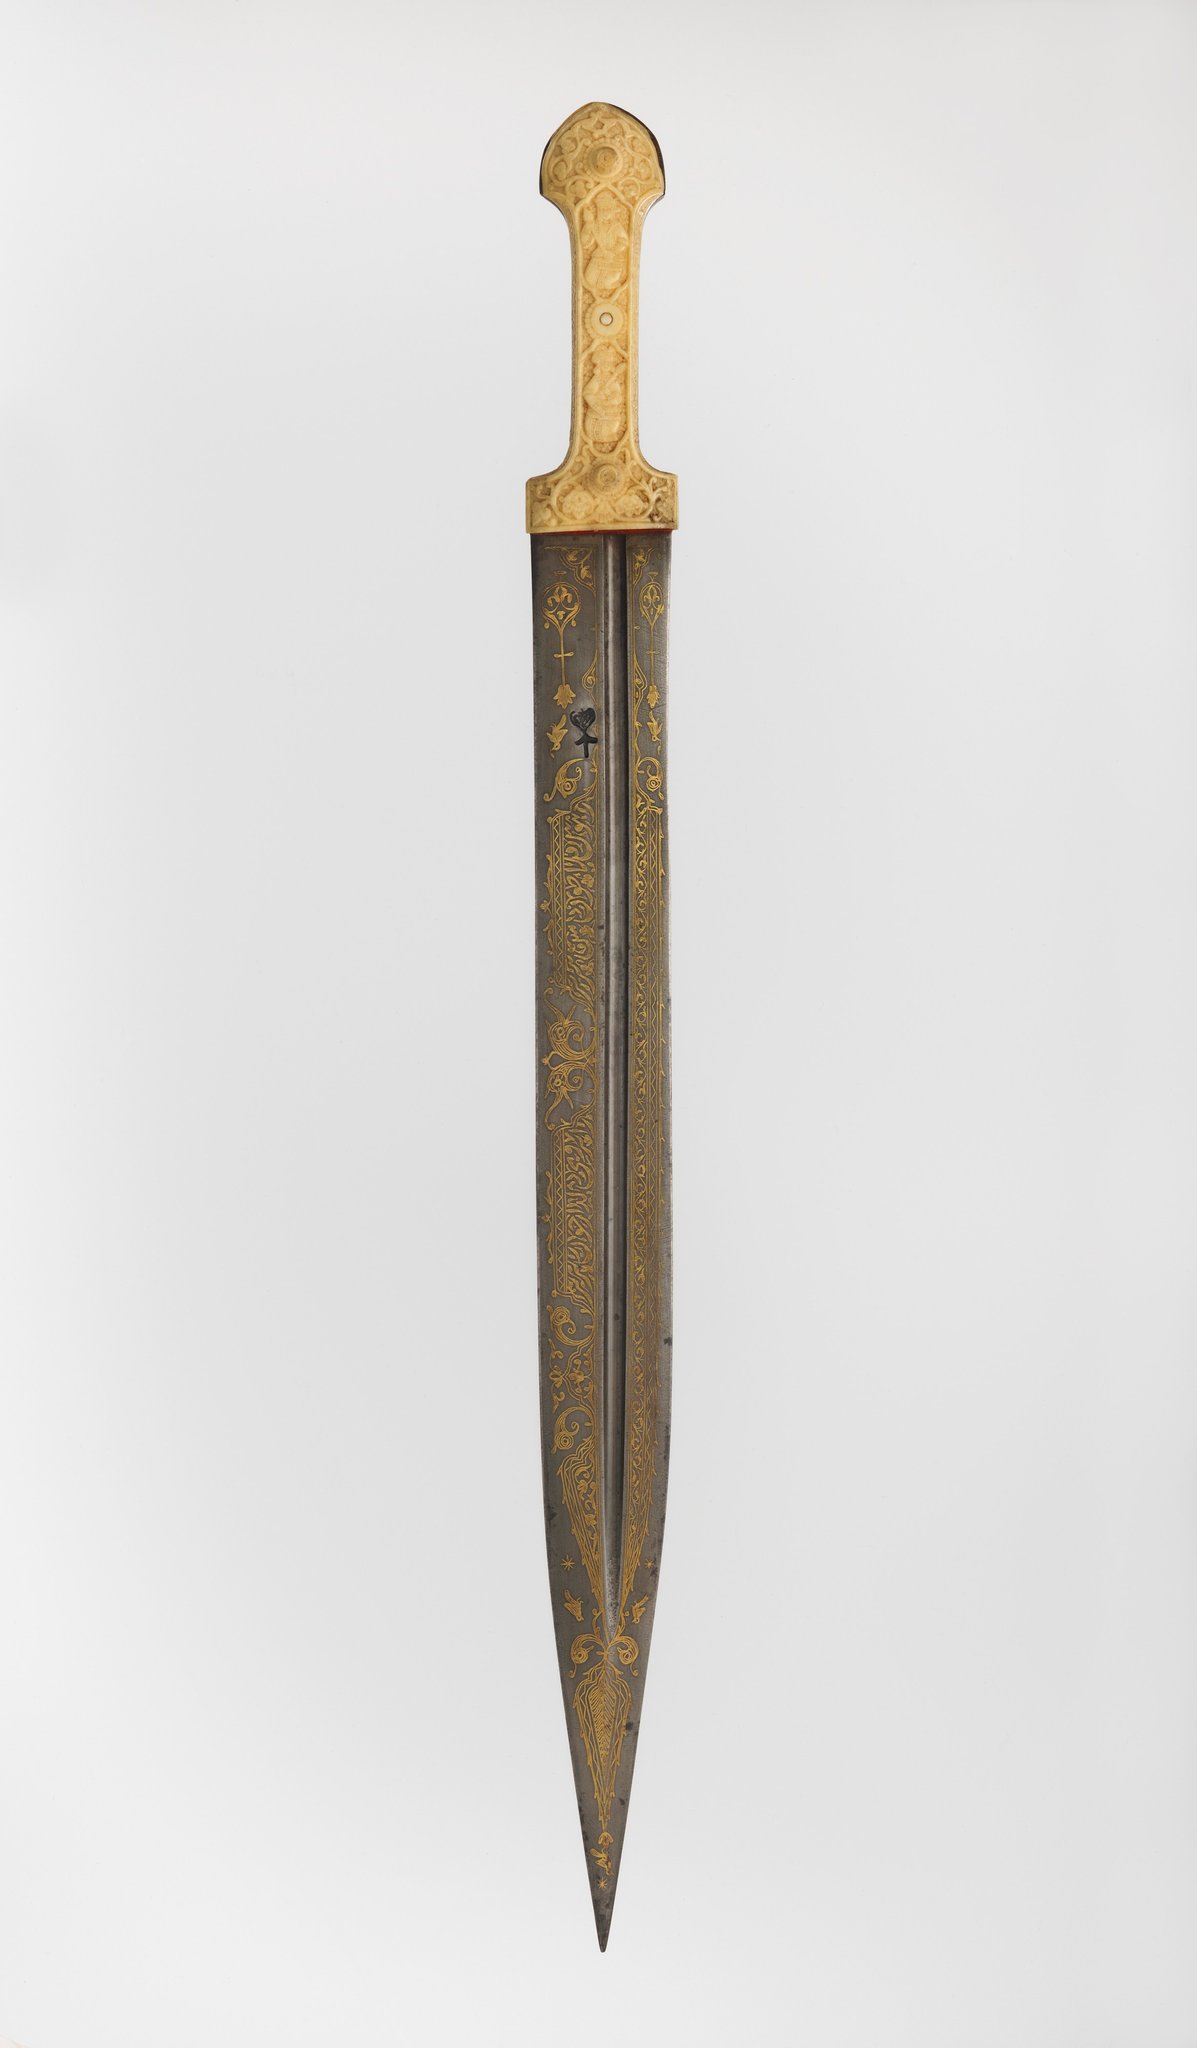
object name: dagger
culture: circassian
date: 1701-1900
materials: brass, ivory, steel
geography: north caucasus